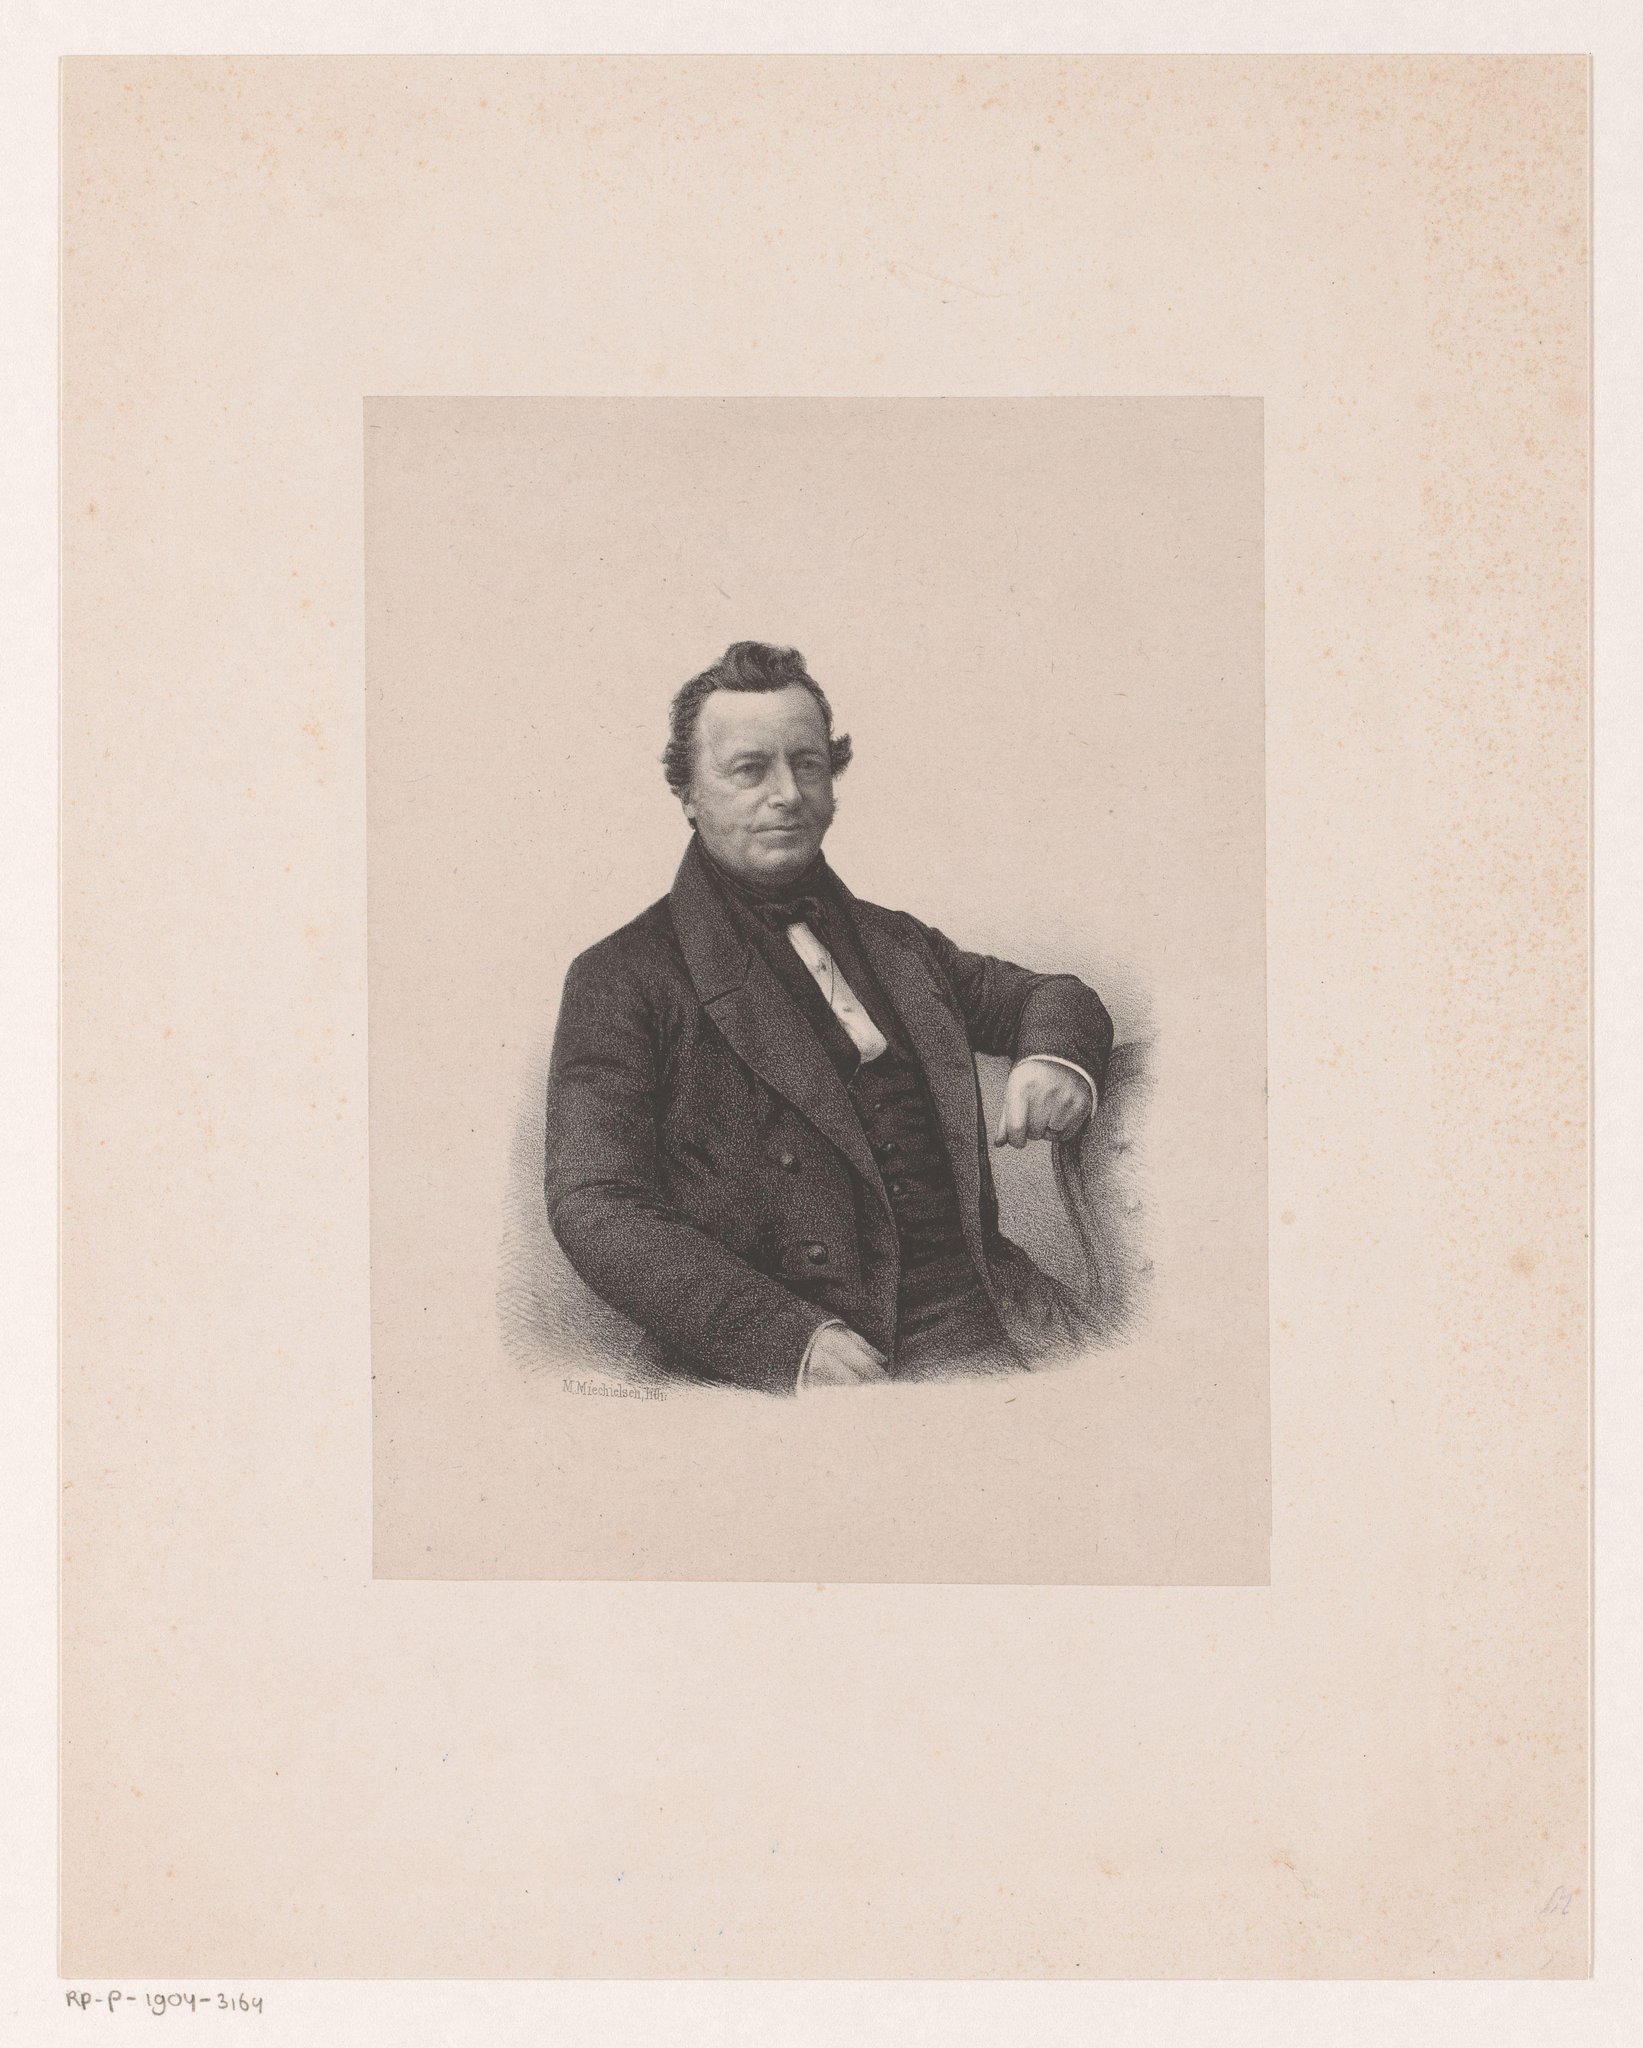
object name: print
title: Portret van een onbekende man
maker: matthijs willem gerardus michielsen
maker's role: print maker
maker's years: 1824-1876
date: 1834-1876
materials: paper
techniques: lithograph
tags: historical persons (+ half-length portrait)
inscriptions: collector's mark: Lugt 2228